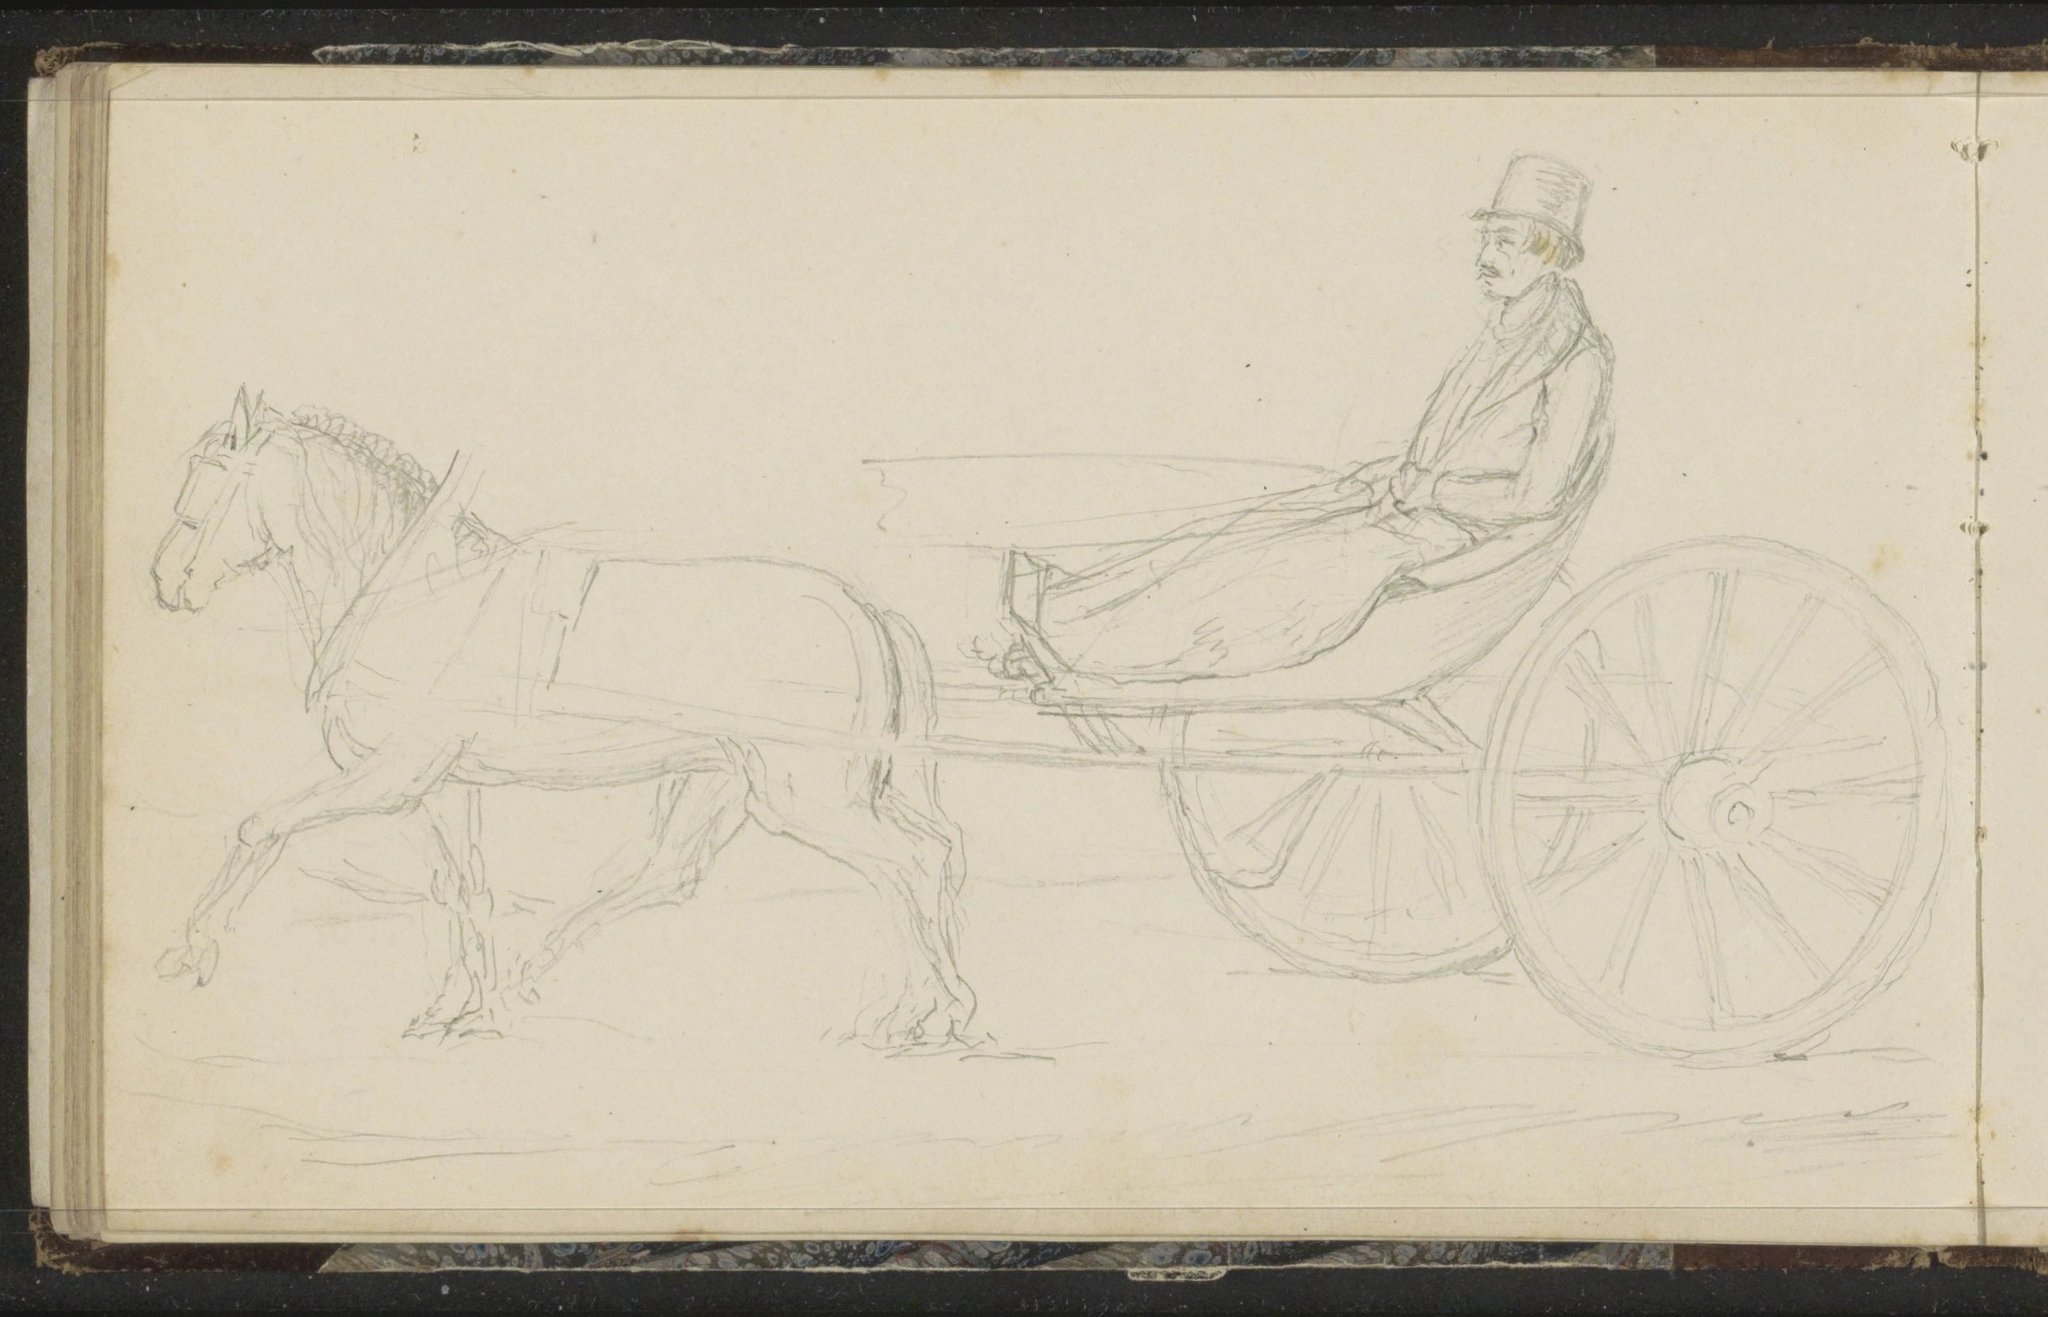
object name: sketchbook leaf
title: Man in een open paardenkoets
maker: christian heinrich gottlieb steuerwald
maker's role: draughtsman, print maker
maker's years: 1802-1874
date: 1845-1848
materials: paper, pencil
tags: two-wheeled vehicle drawn by one animal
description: Blad 37 verso uit een schetsboek met 61 bladen.